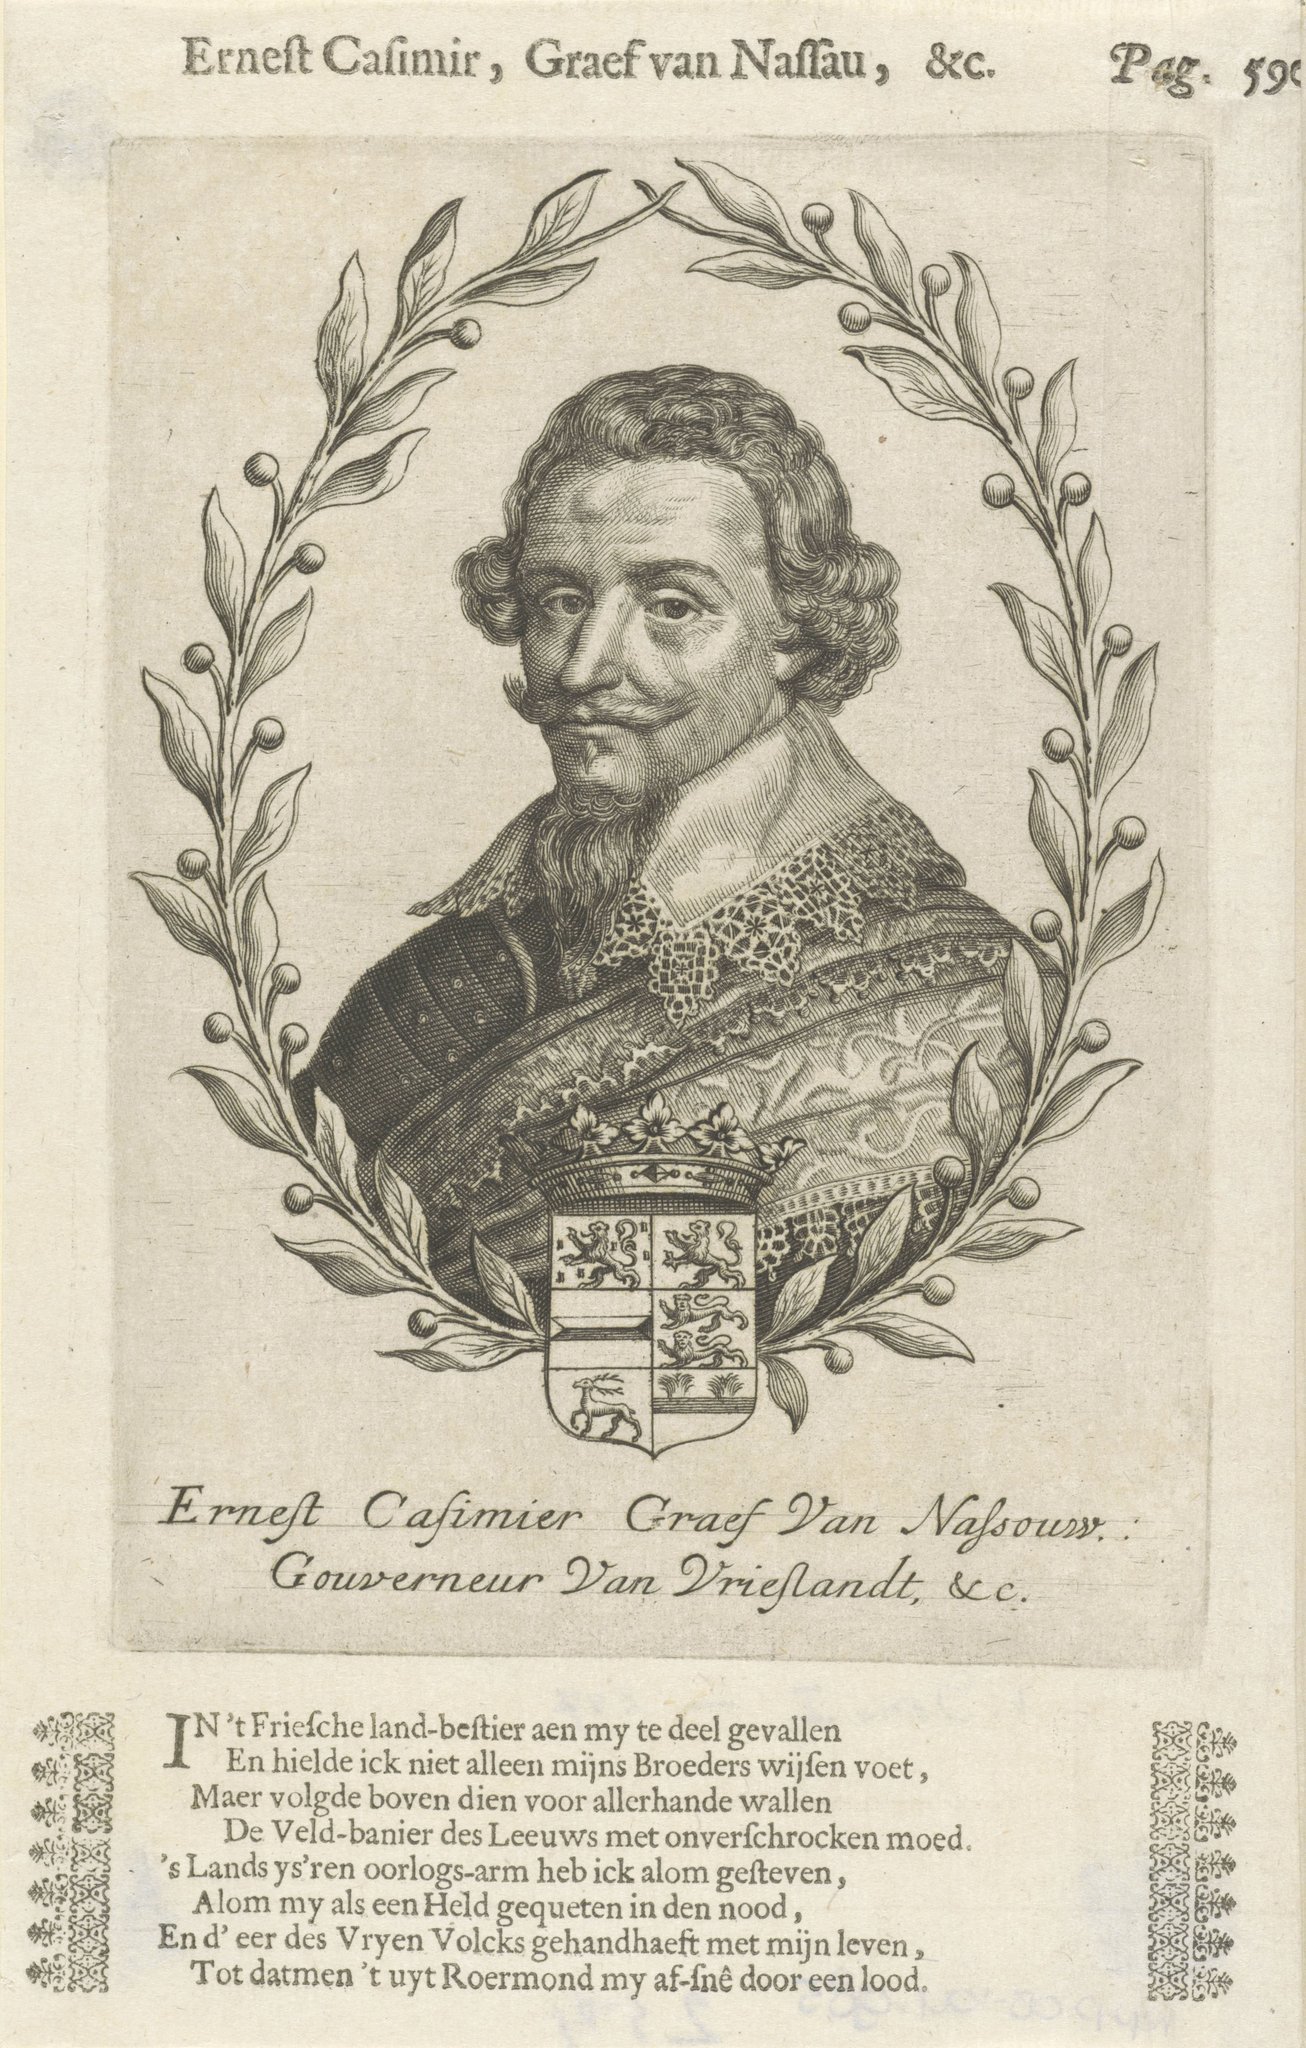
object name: print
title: Portret van Ernst Casimir, graaf van Nassau-Dietz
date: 1667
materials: paper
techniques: engraving, etching, letterpress printing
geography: the hague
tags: ernst casimir graaf van nassau-dietz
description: De hier vermelde titel verwijst naar de hoogst verkregen titel van de geportretteerde, niet per se naar de titel die de geportretteerde op deze voorstelling draagt. Prent uit: Scriverius, Petrus. Oude en nieuwe beschryvinghe van Holland, Zeeland en Vriesland. Den Haag: Levijn van Dijck, 1667.